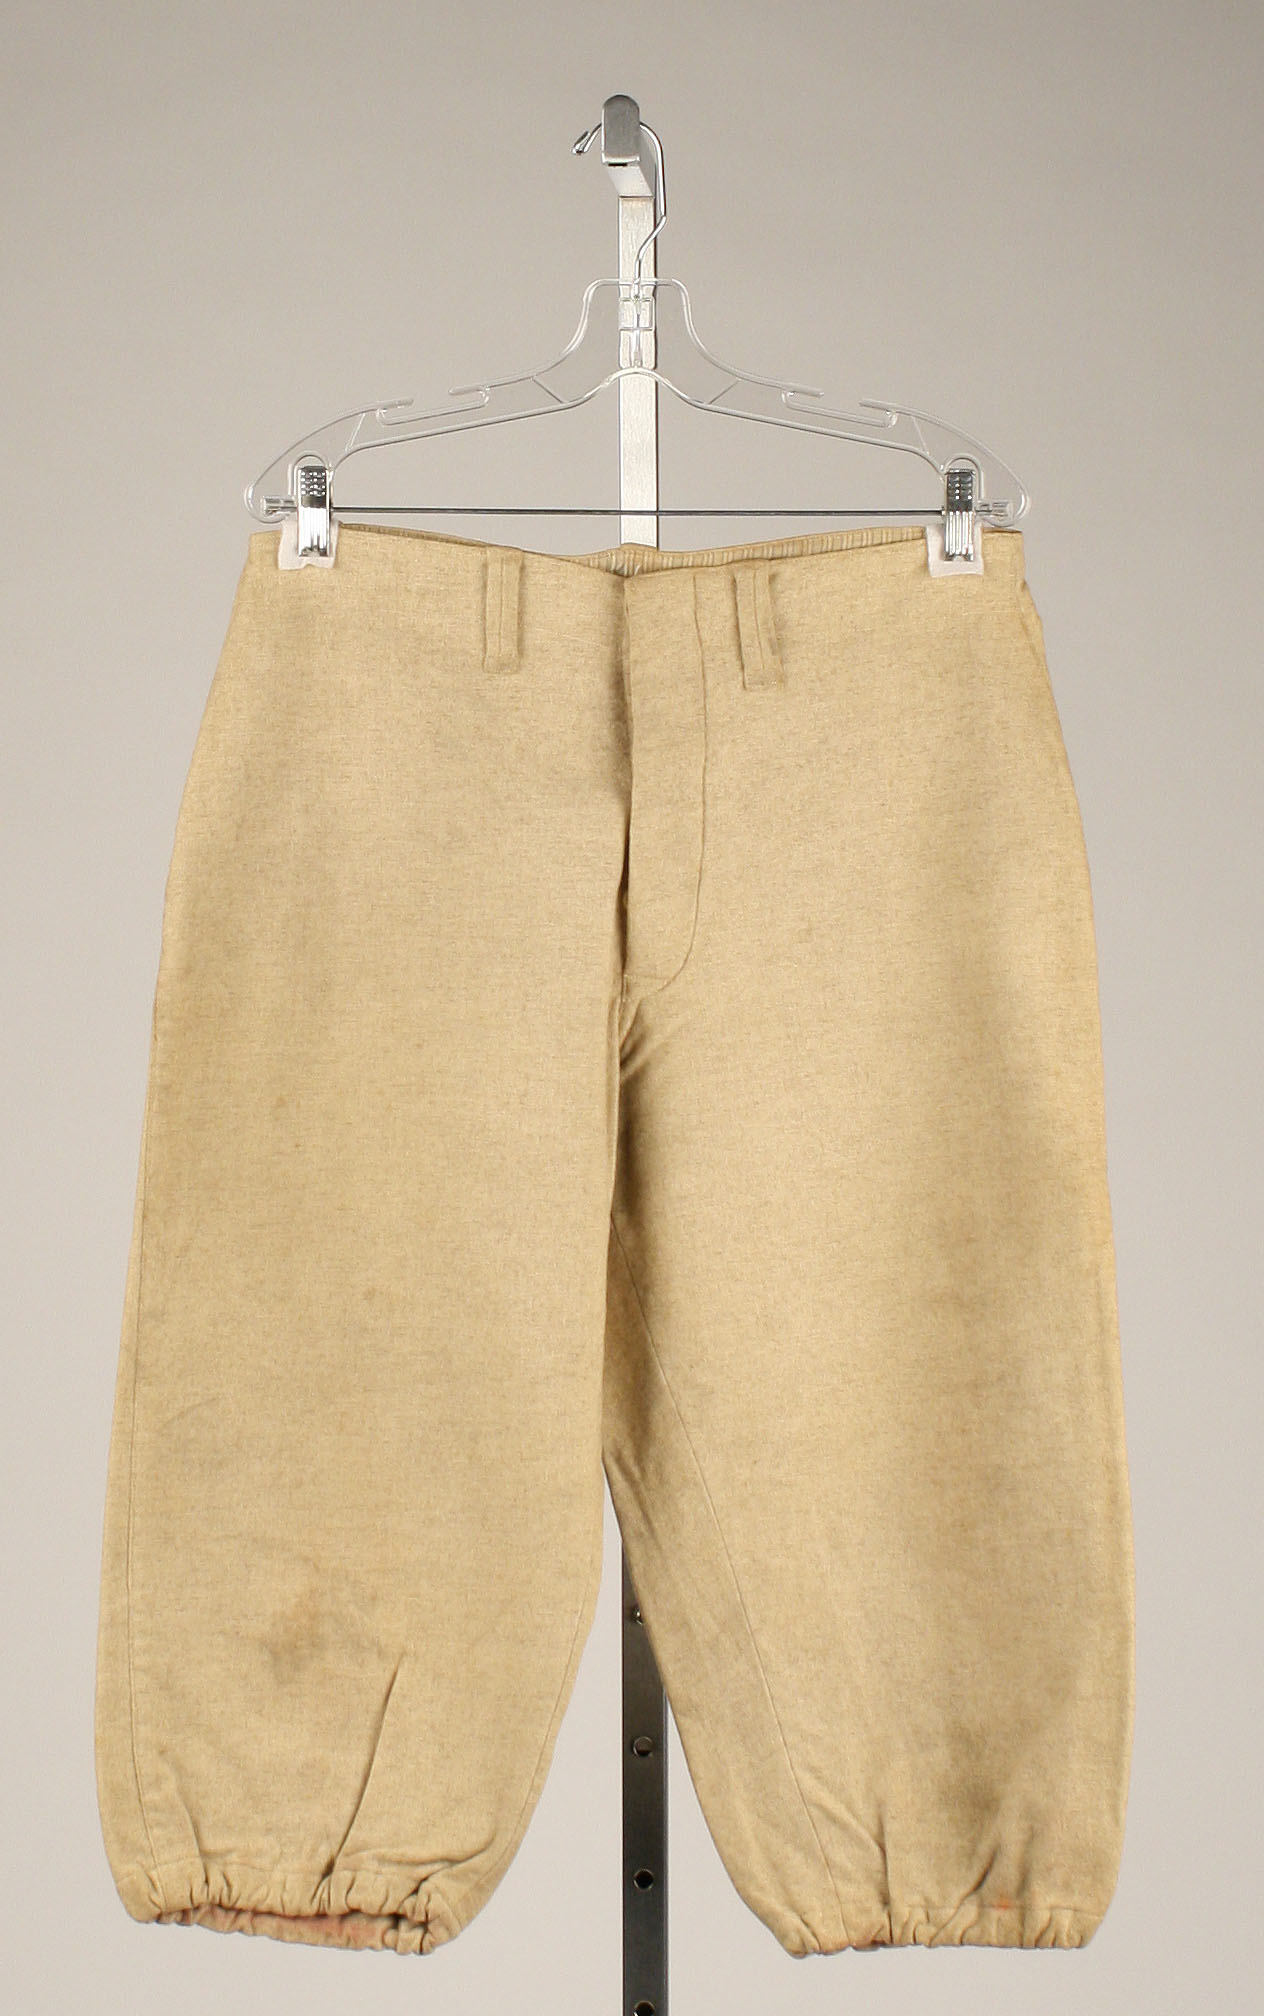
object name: knickerbockers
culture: american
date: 1901-1933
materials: wool